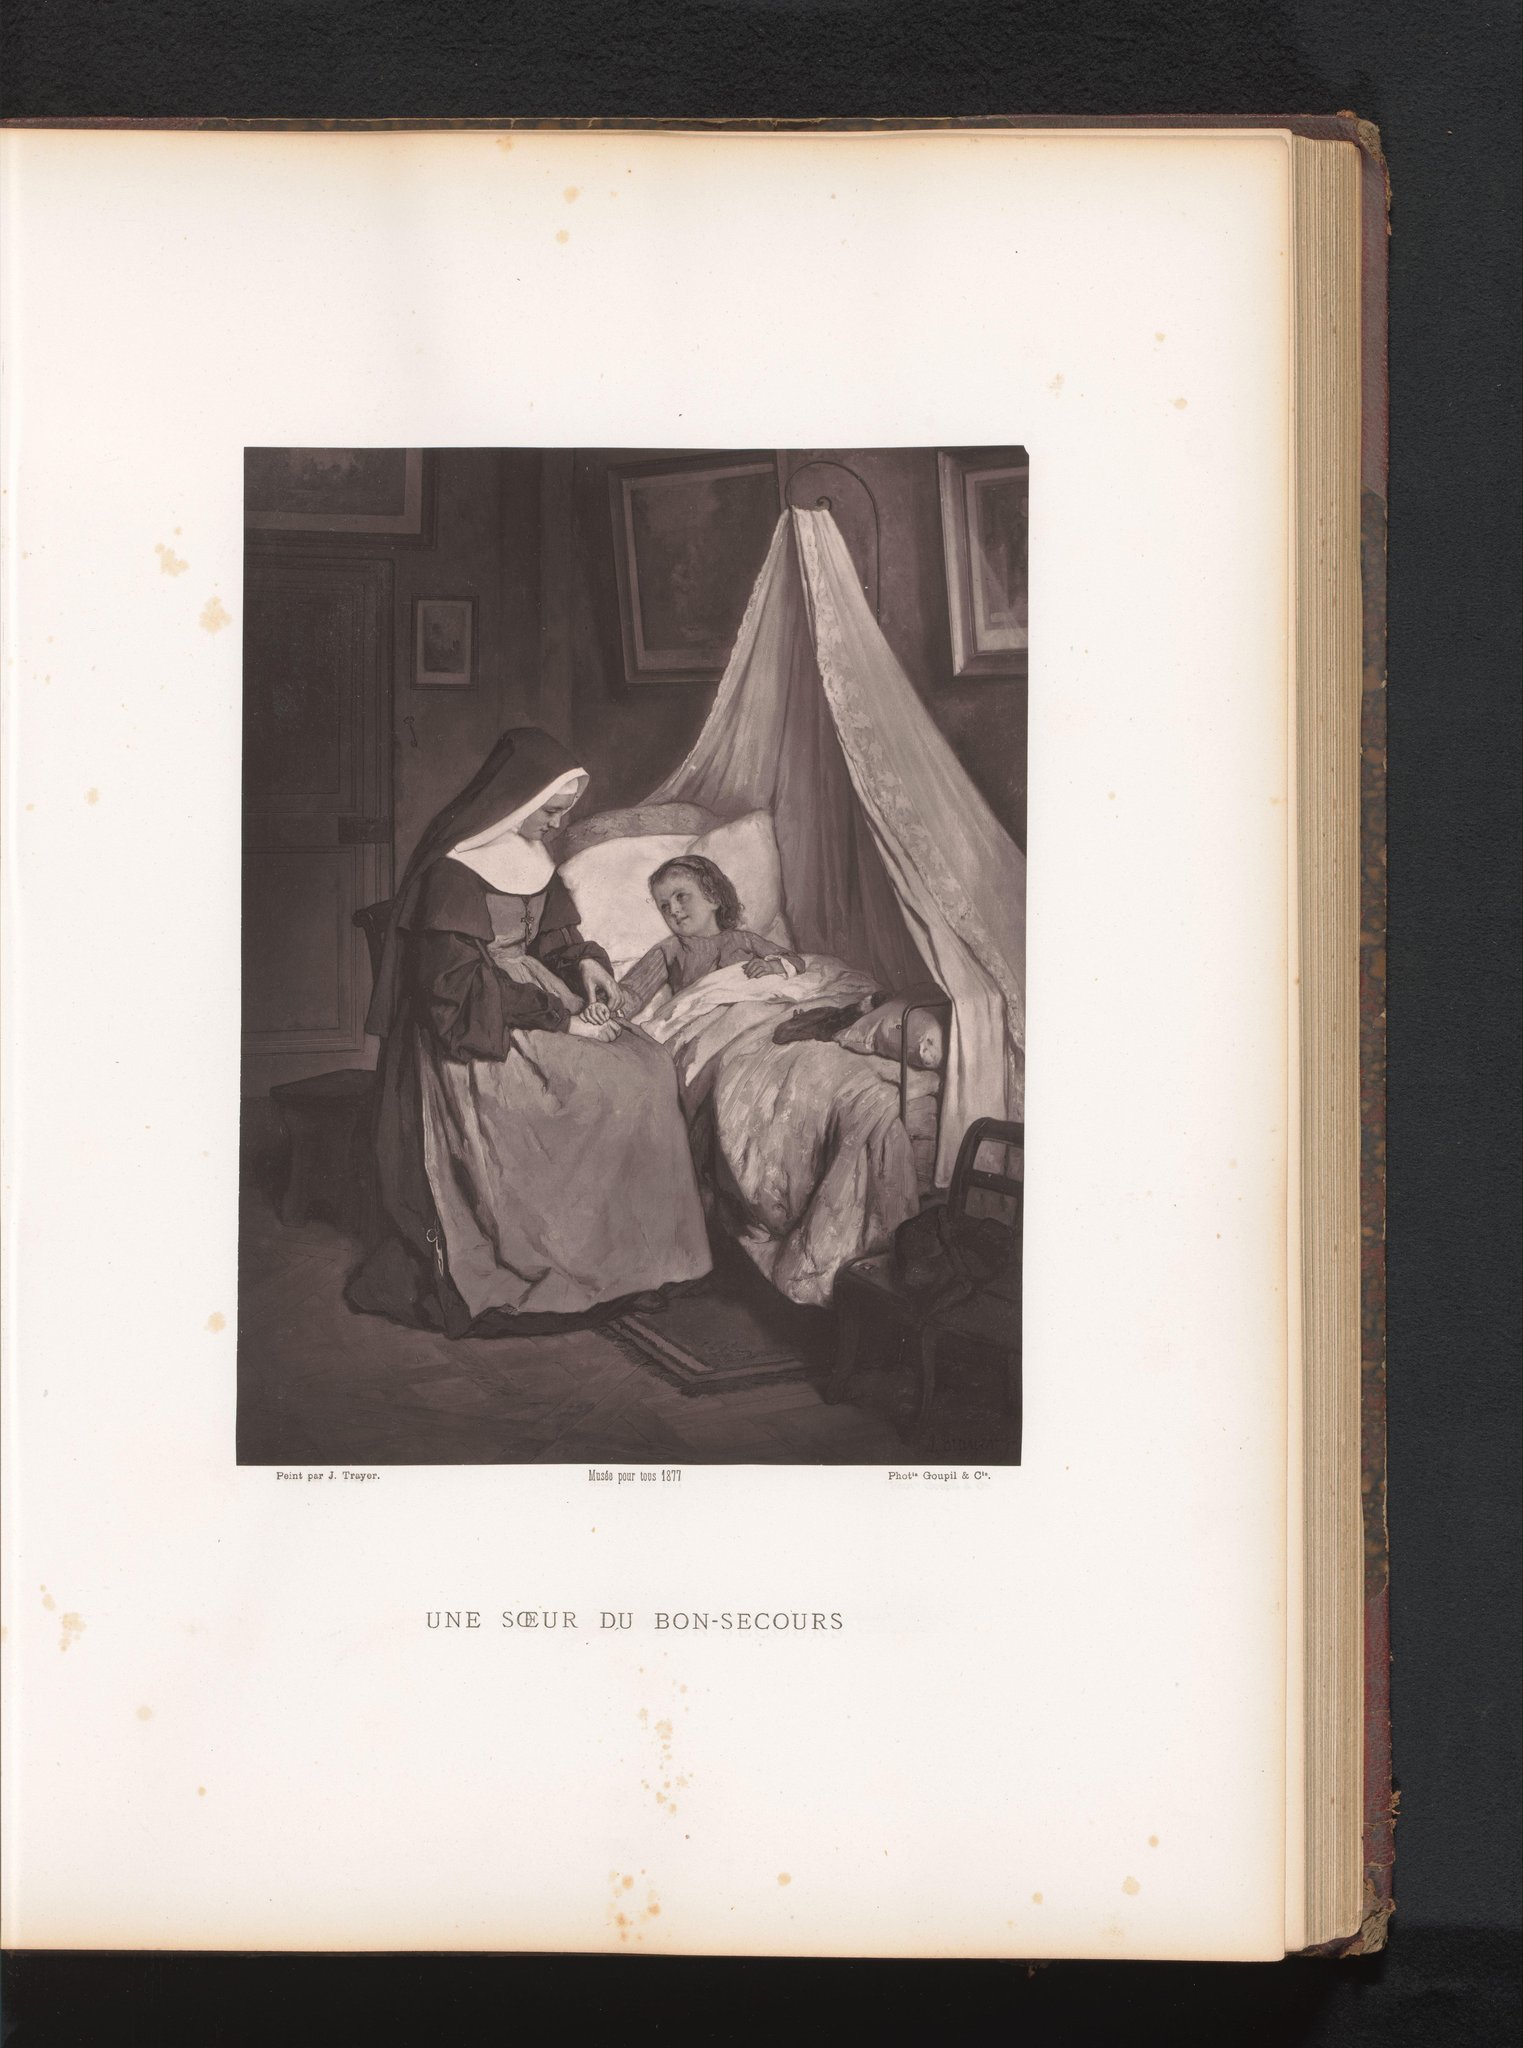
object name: reproduction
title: Une soeur du bon-secours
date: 1872-1879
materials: paper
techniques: woodburytype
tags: sick-bed, nursing, tending the sick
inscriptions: inscription: ‘Musée pour tous 1877’